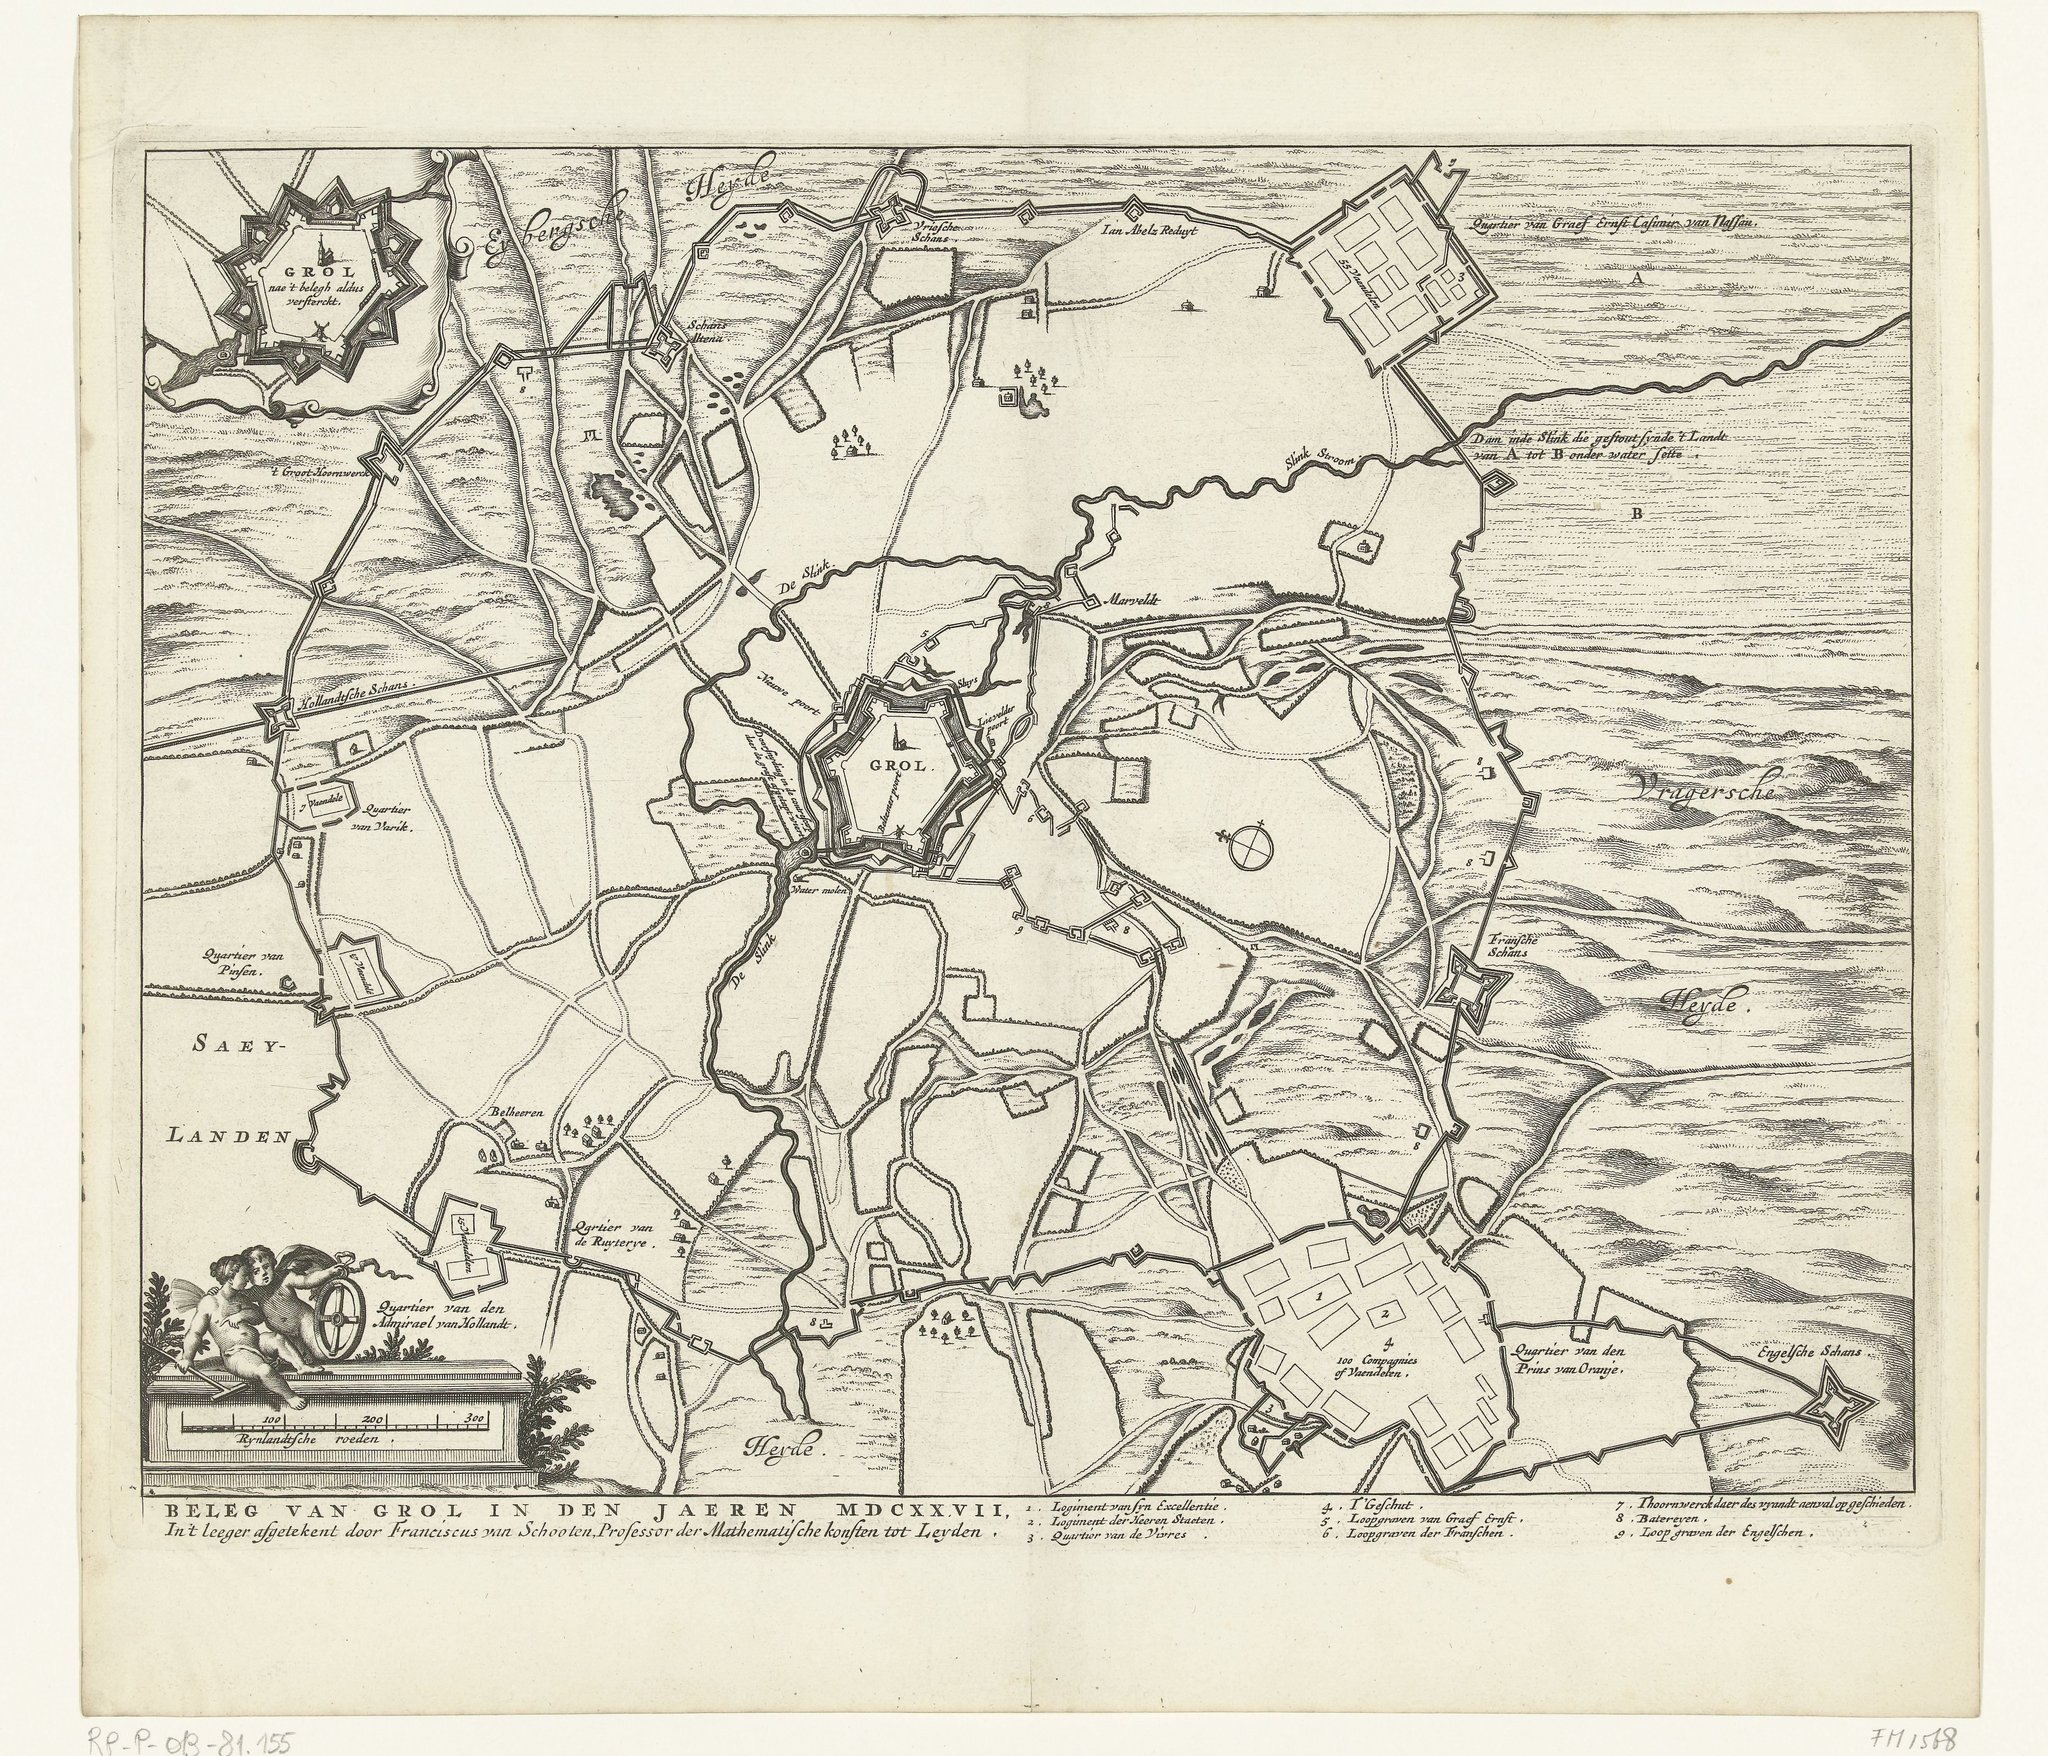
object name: map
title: Beleg van Grol in den jaeren MDCXXVII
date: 1681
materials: paper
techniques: engraving, etching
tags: the hague, frederick henry (prince of orange), maps of separate countries or regions, siege, position war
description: Prent ook gebruikt in: Groot, Hugo de. Nederlandtsche Jaerboeken en Historien (...). Amsterdam: weduwe Joannes van Someren, Abraham Wolfgang en Hendrick en Dirk Boom, 1681. Kopie naar de prent gebruikt in: Blaeu, Johannes Willemszoon. Novum ac magnum theatrum urbium Belgicae (...). 2 delen. 1e druk. Amsterdam: Johannes Willemszoon Blaeu, 1649, dl. 1. Wellicht uit hetzelfde werk als FMH 1573.